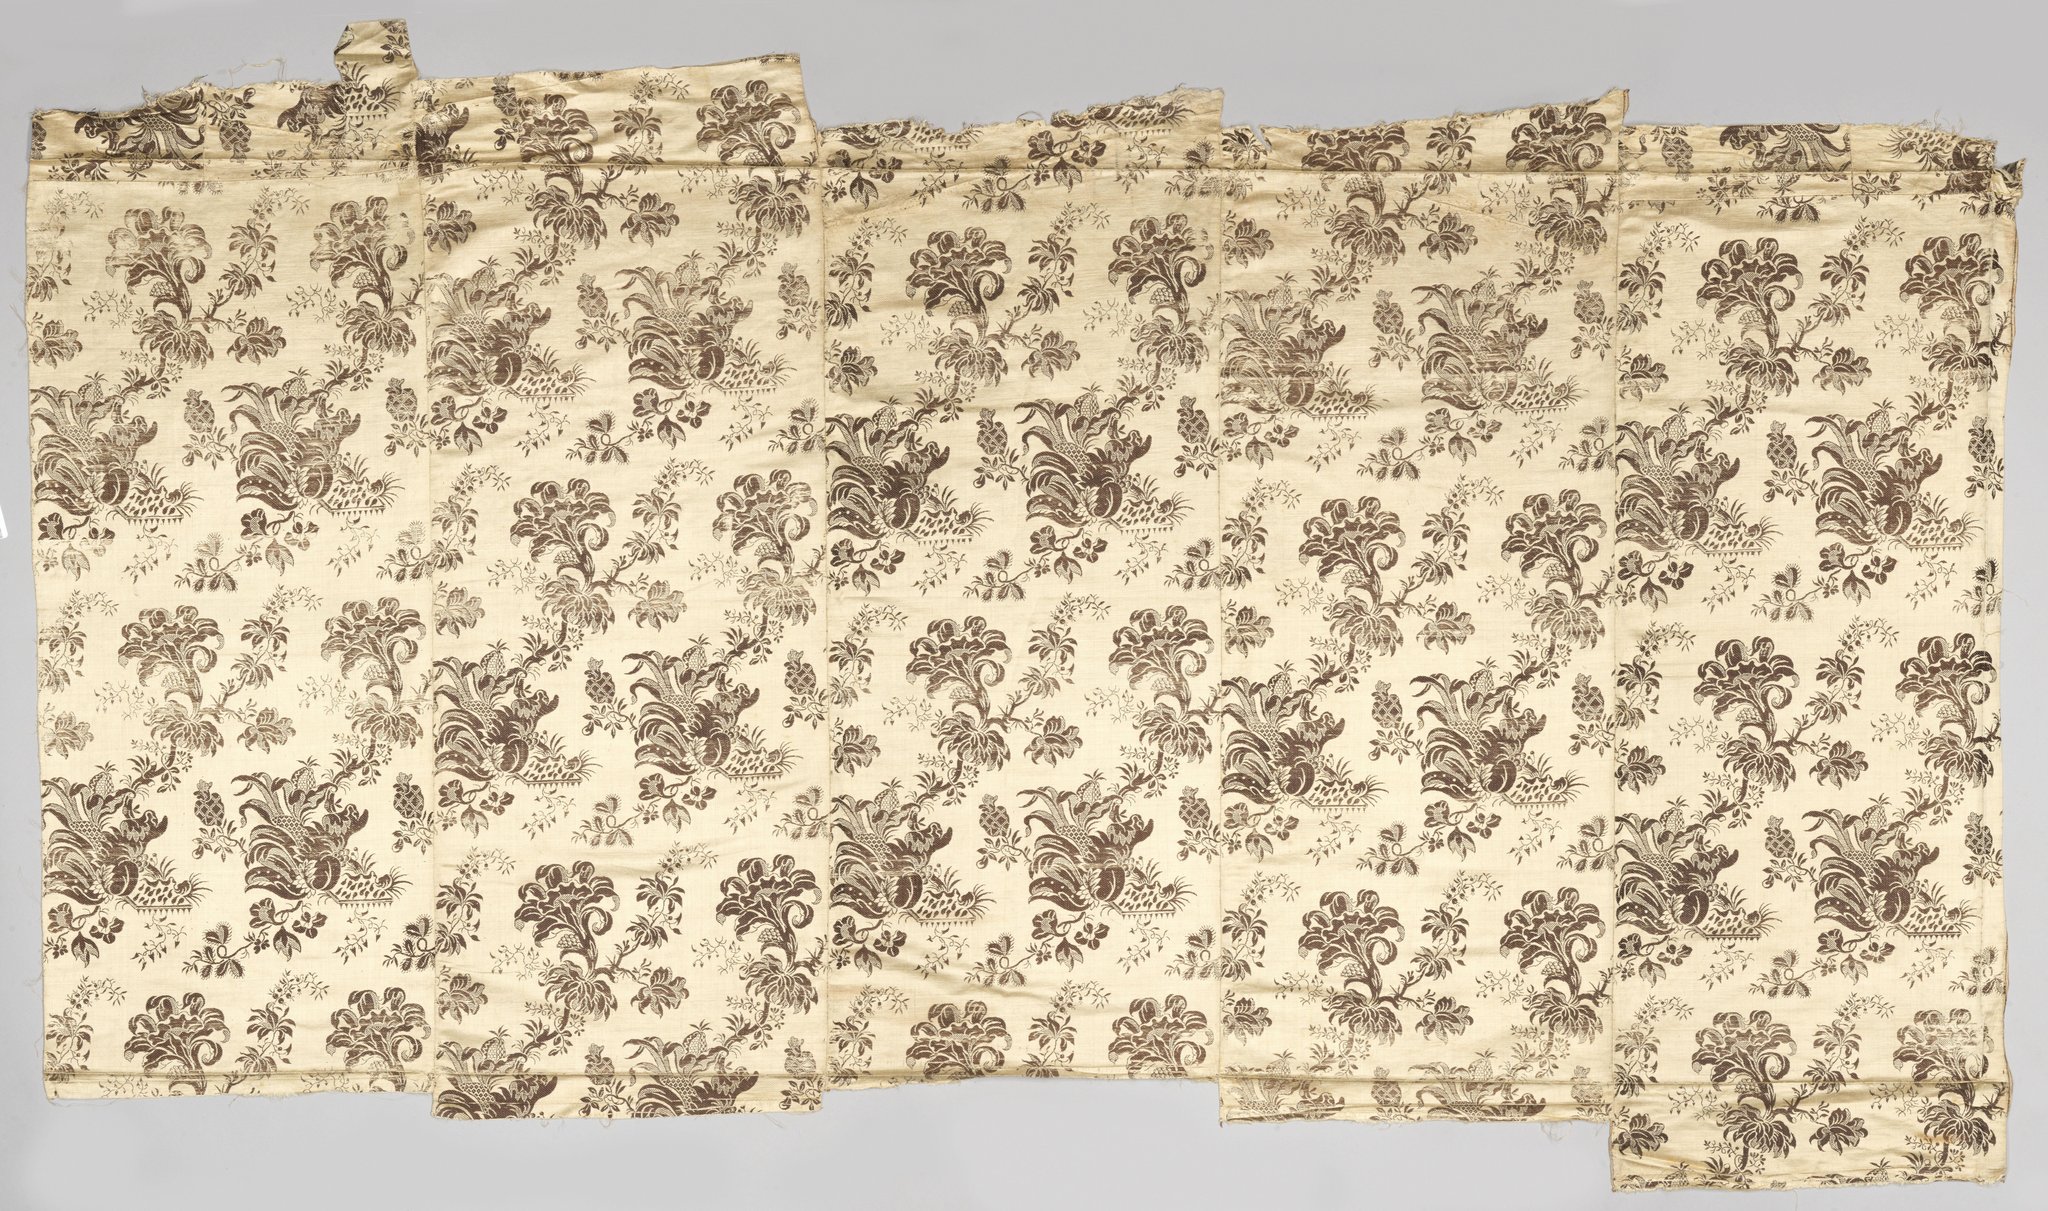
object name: silk textile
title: Fragment van vijf aan elkaar genaaide banen zijdedamast met o.a. horizontale rijen met grote bloemen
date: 1880-1920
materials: silk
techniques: damask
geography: france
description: Fragment van vijf aan elkaar genaaide banen gelanceerde zijdedamast met een dessin van horizontale rijen grootschalige bloemen met omhoogrijzende tak waaraan bloemen en bladeren, gelegen op een tafelblad afgezet met een gepunte rand in bruin op cremekleurig fond. Navolging Franse weefsels uit ca. 1730.